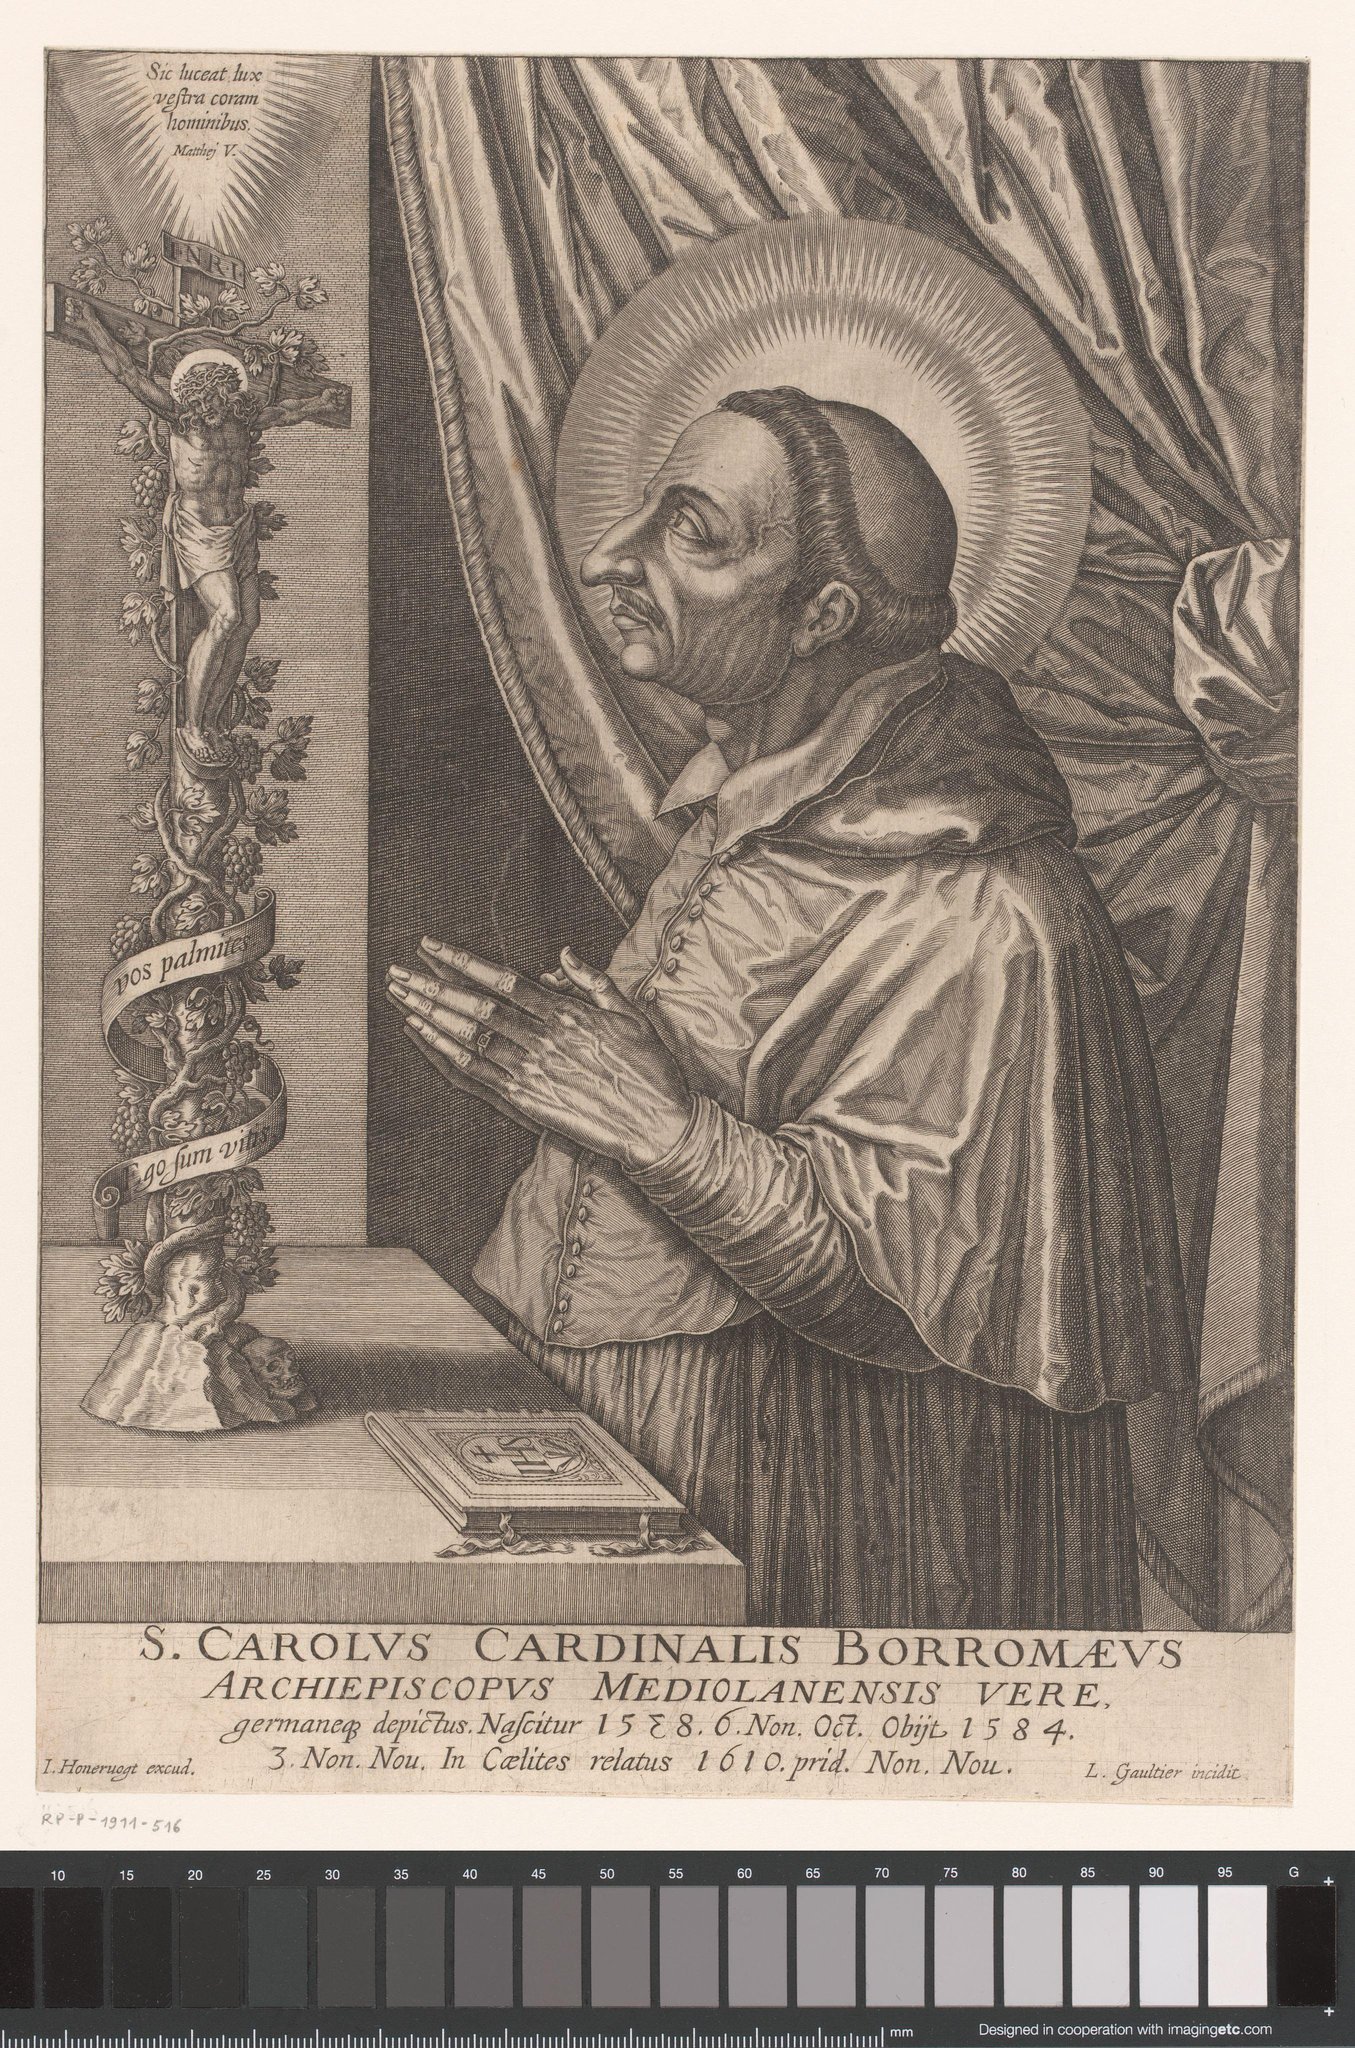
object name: print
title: S. Carolus Cardinalis Borromaeus (...)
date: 1610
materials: paper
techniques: engraving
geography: paris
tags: historical persons, crucifix ~ personal devotion, one person praying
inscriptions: collector's mark: Lugt 345, collector's mark: Lugt 2228, collector's mark: Lugt 1375, collector's mark: Lugt 151